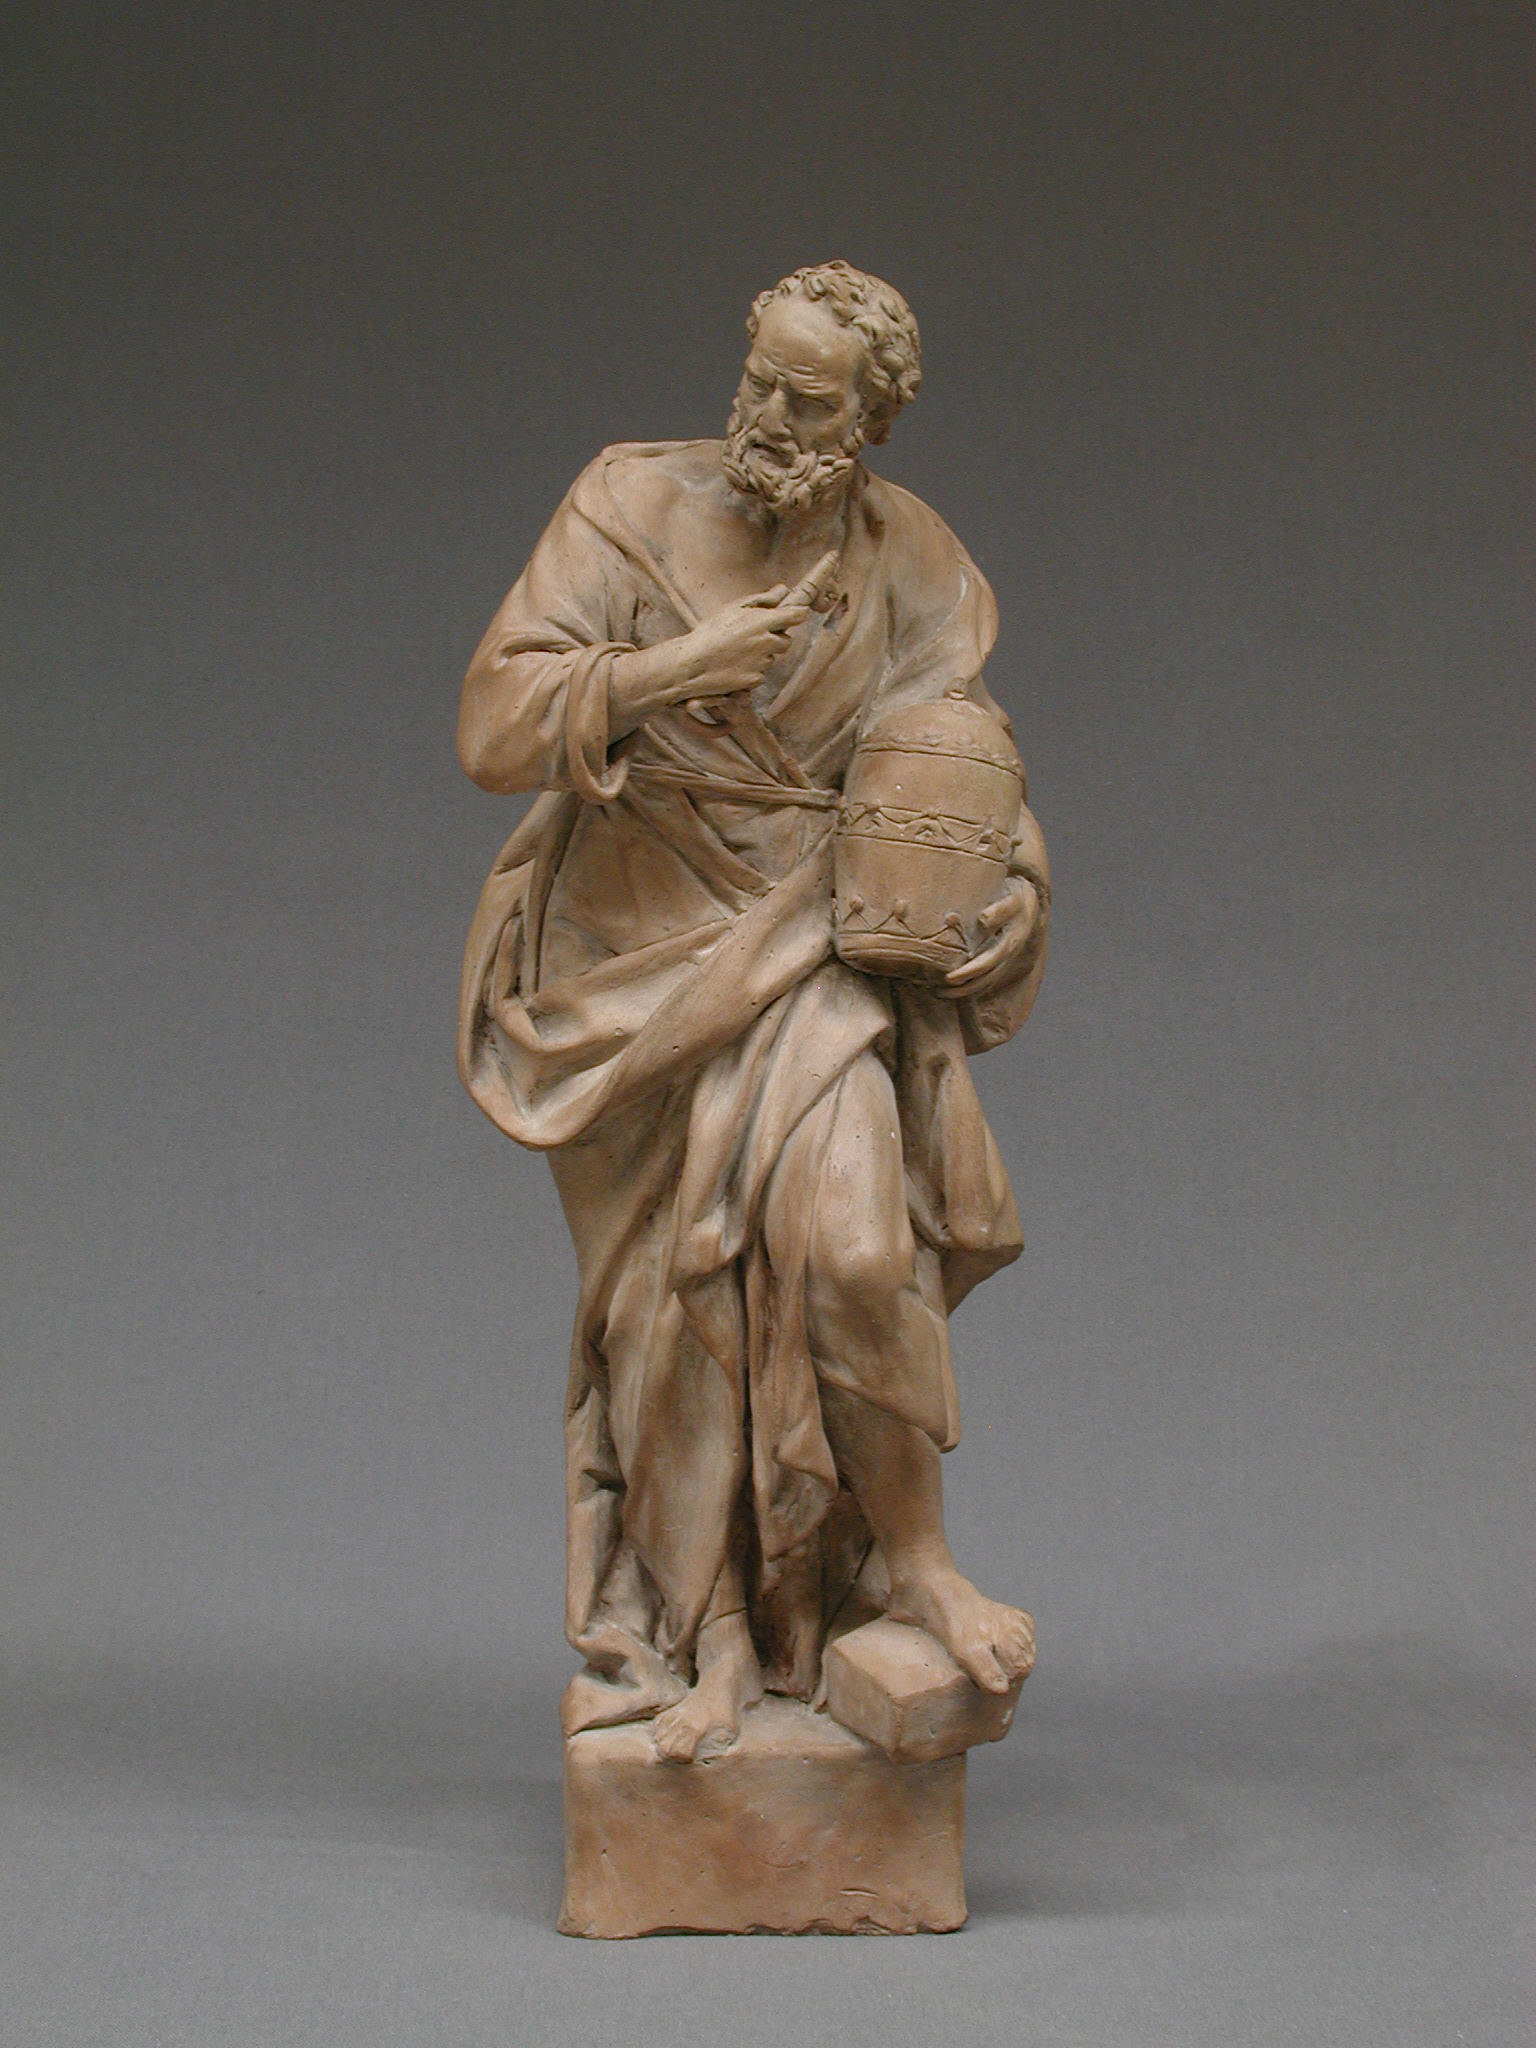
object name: statuette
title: Saint Peter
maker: giuseppe picano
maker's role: artist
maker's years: 1732-1810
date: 1780-1789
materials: terracotta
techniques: wash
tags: saint peter